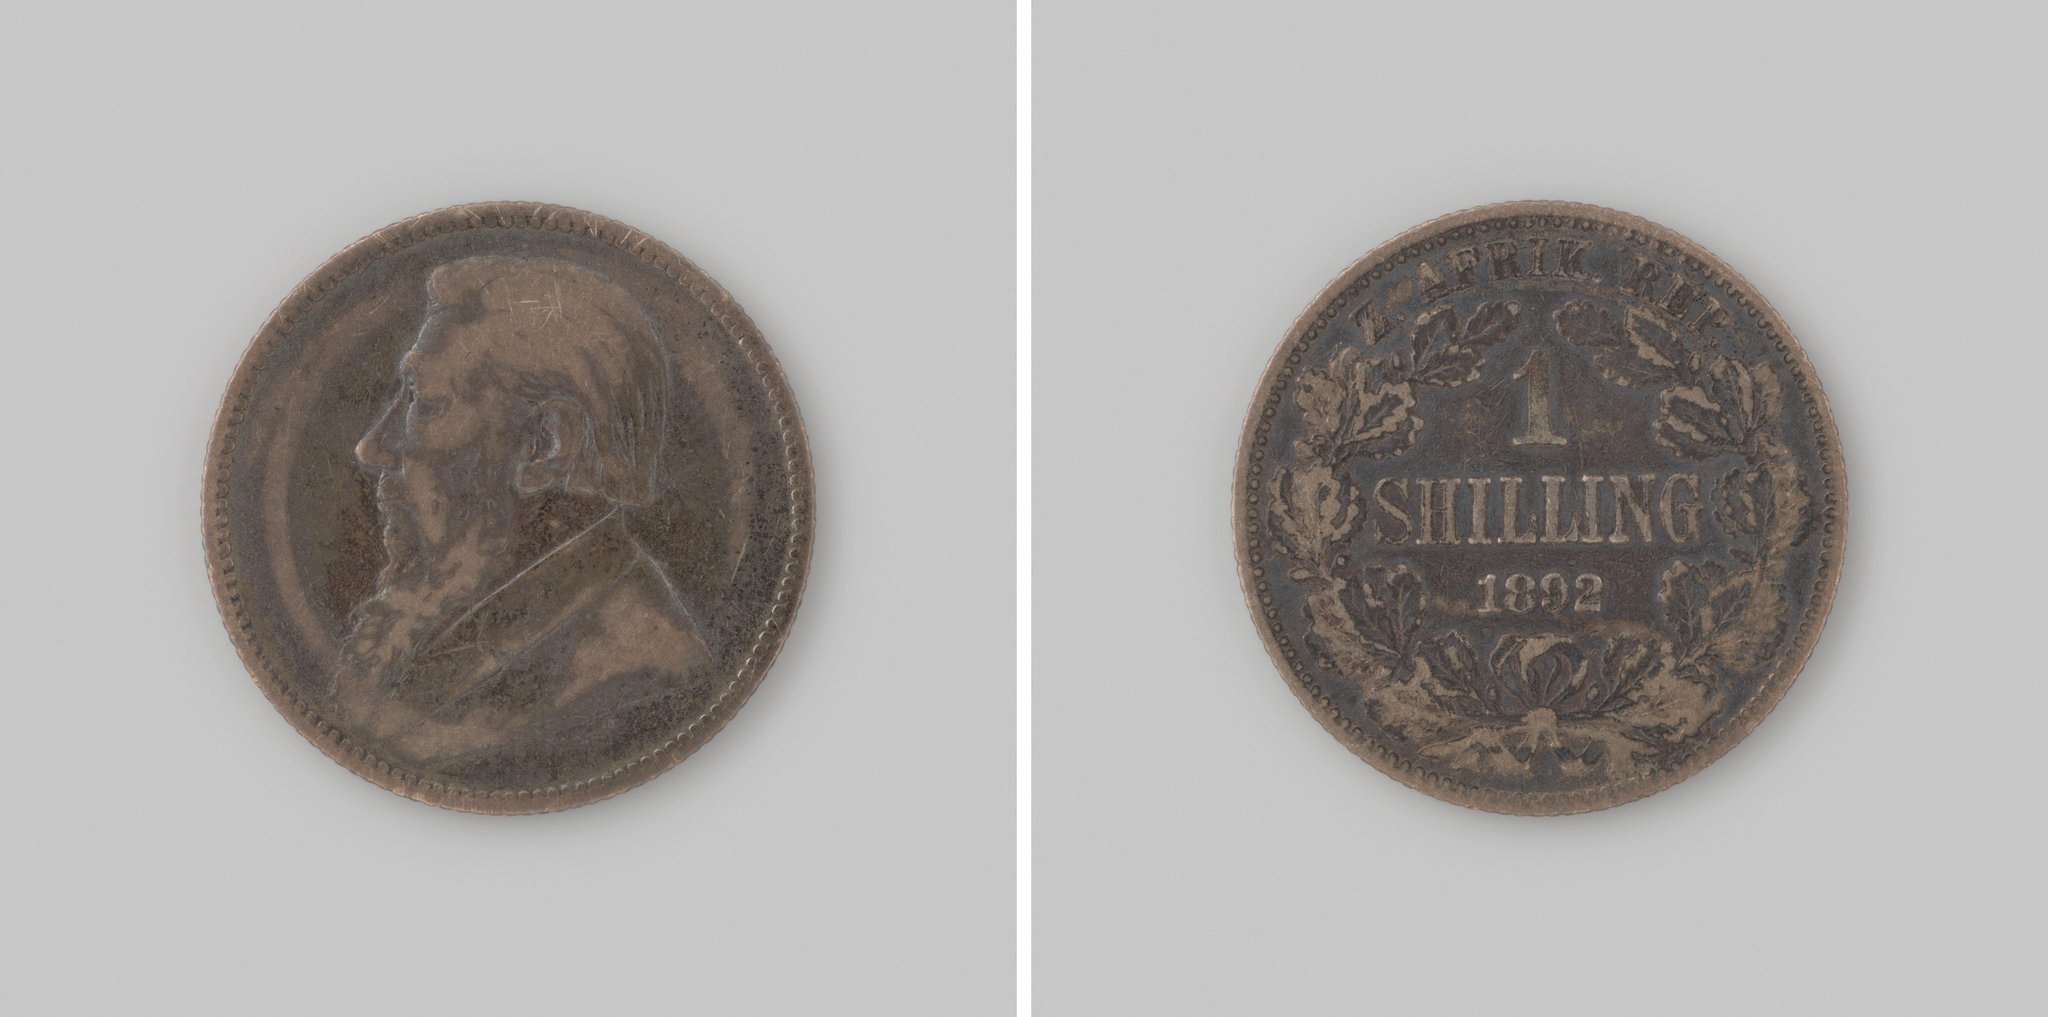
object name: coin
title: Shilling van Zuid-Afrika, de Zuidafrikaansche Republiek (Z.A.R.), 1892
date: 1892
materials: silver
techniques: striking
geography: pretoria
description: Zilveren munt. Voorzijde: borstbeeld van president Krüger naar links. Keerzijde: binnen twee samengebonden takken waarde-aanduiding: 1 shilling in twee regels, waaronder jaartal. Bovenaan Z. Afrik. Rep.